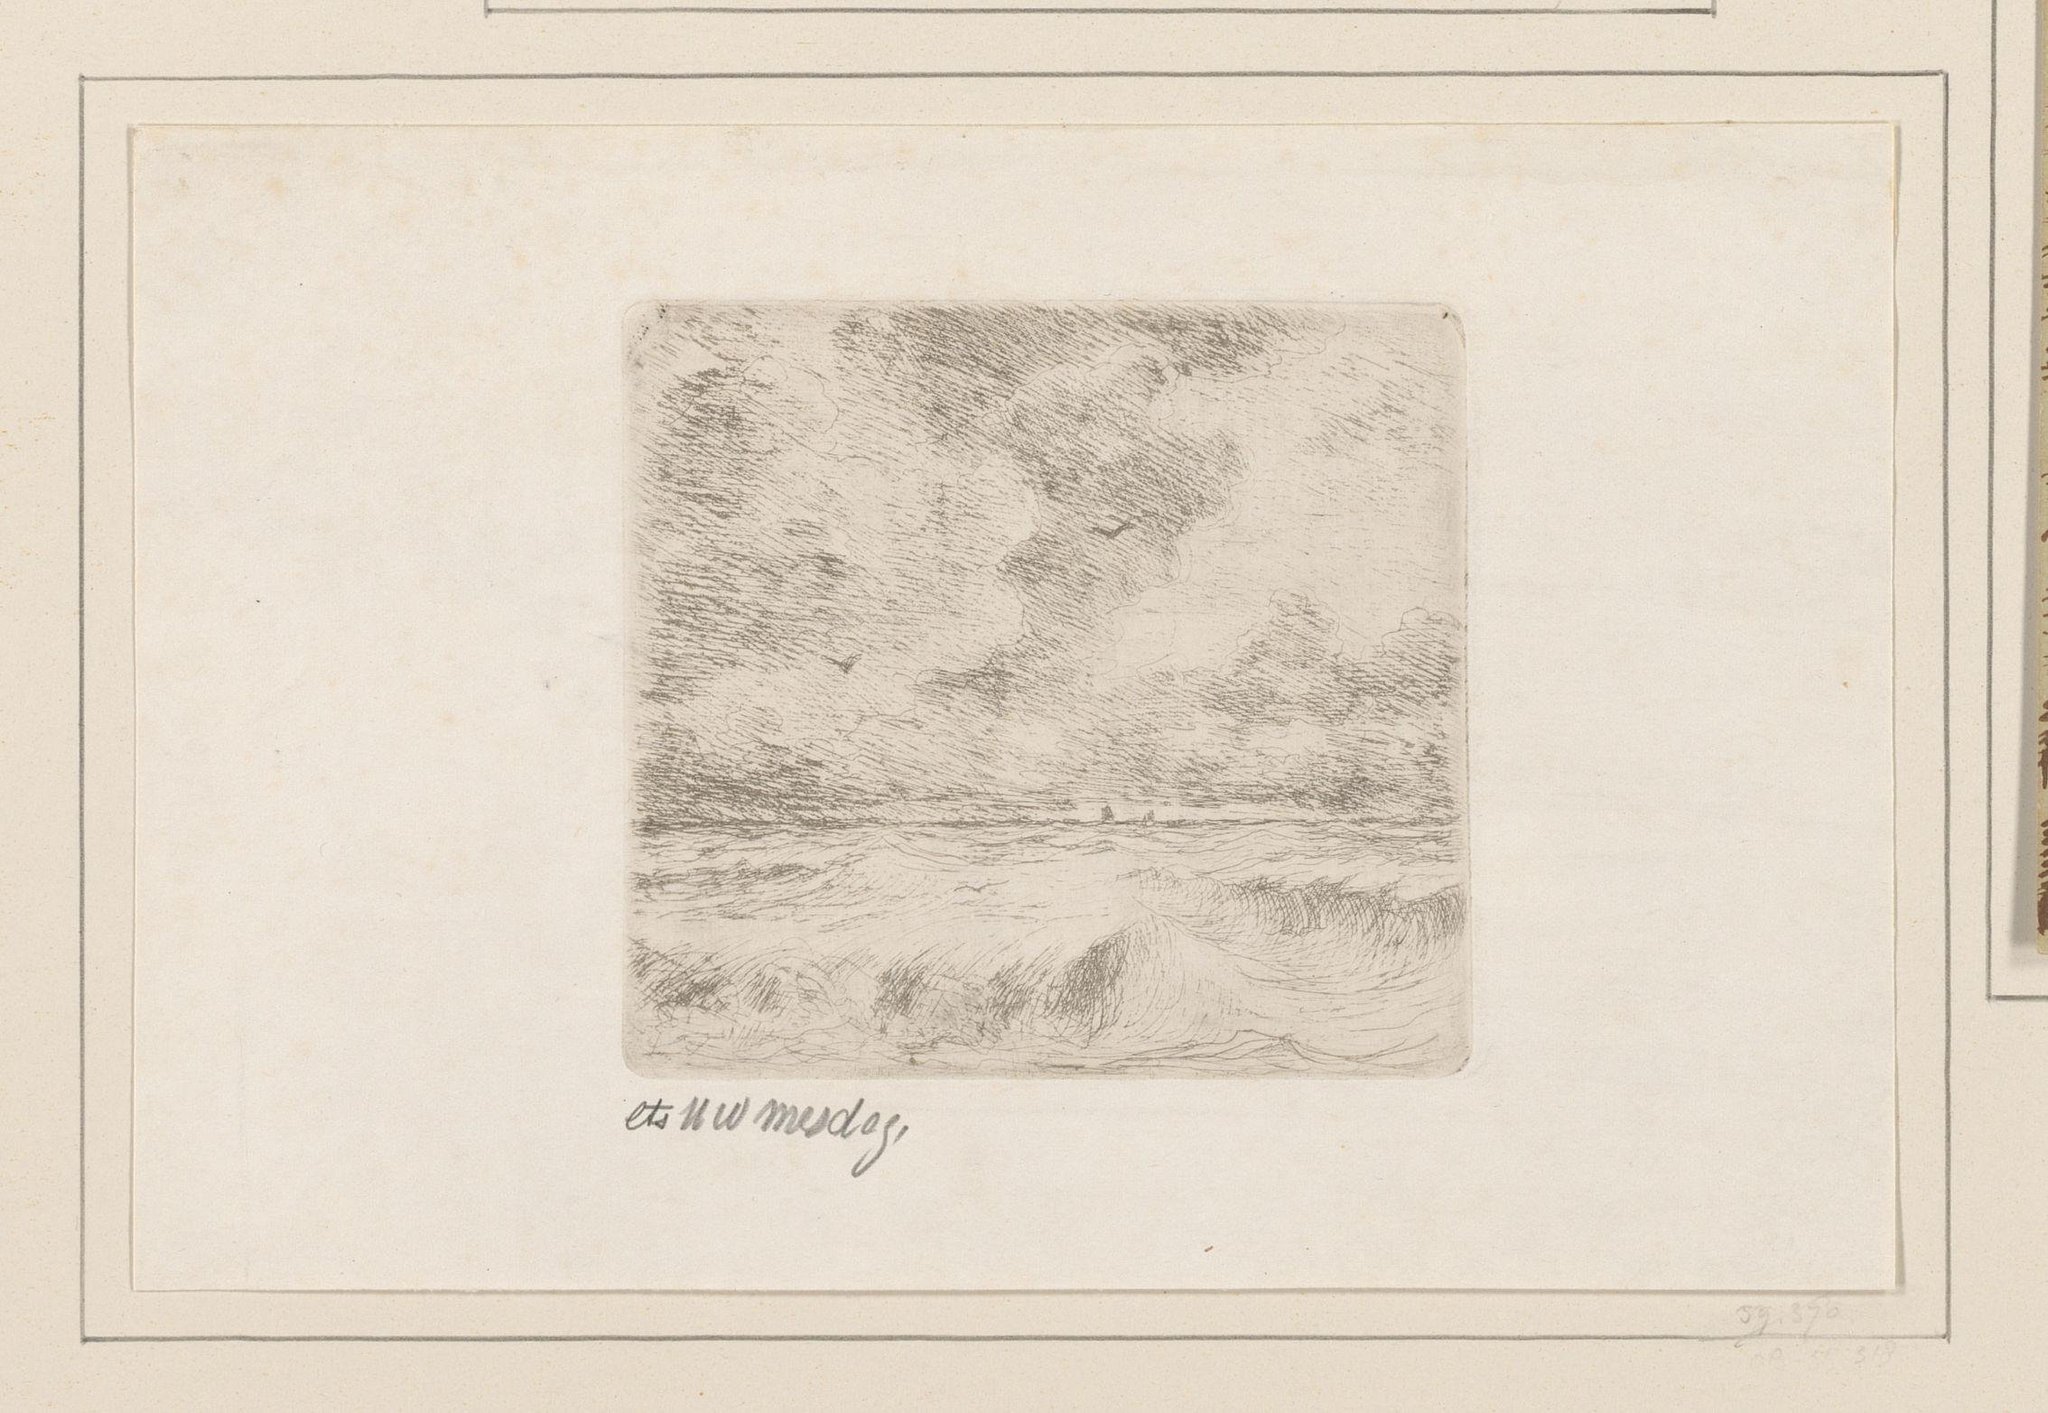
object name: print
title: Zeegezicht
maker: hendrik willem mesdag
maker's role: draughtsman, painter, print maker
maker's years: 1831-1915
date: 1841-1915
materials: paper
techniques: etching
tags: sea (seascape)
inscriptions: inscription: ‘ets HW Mesdag’